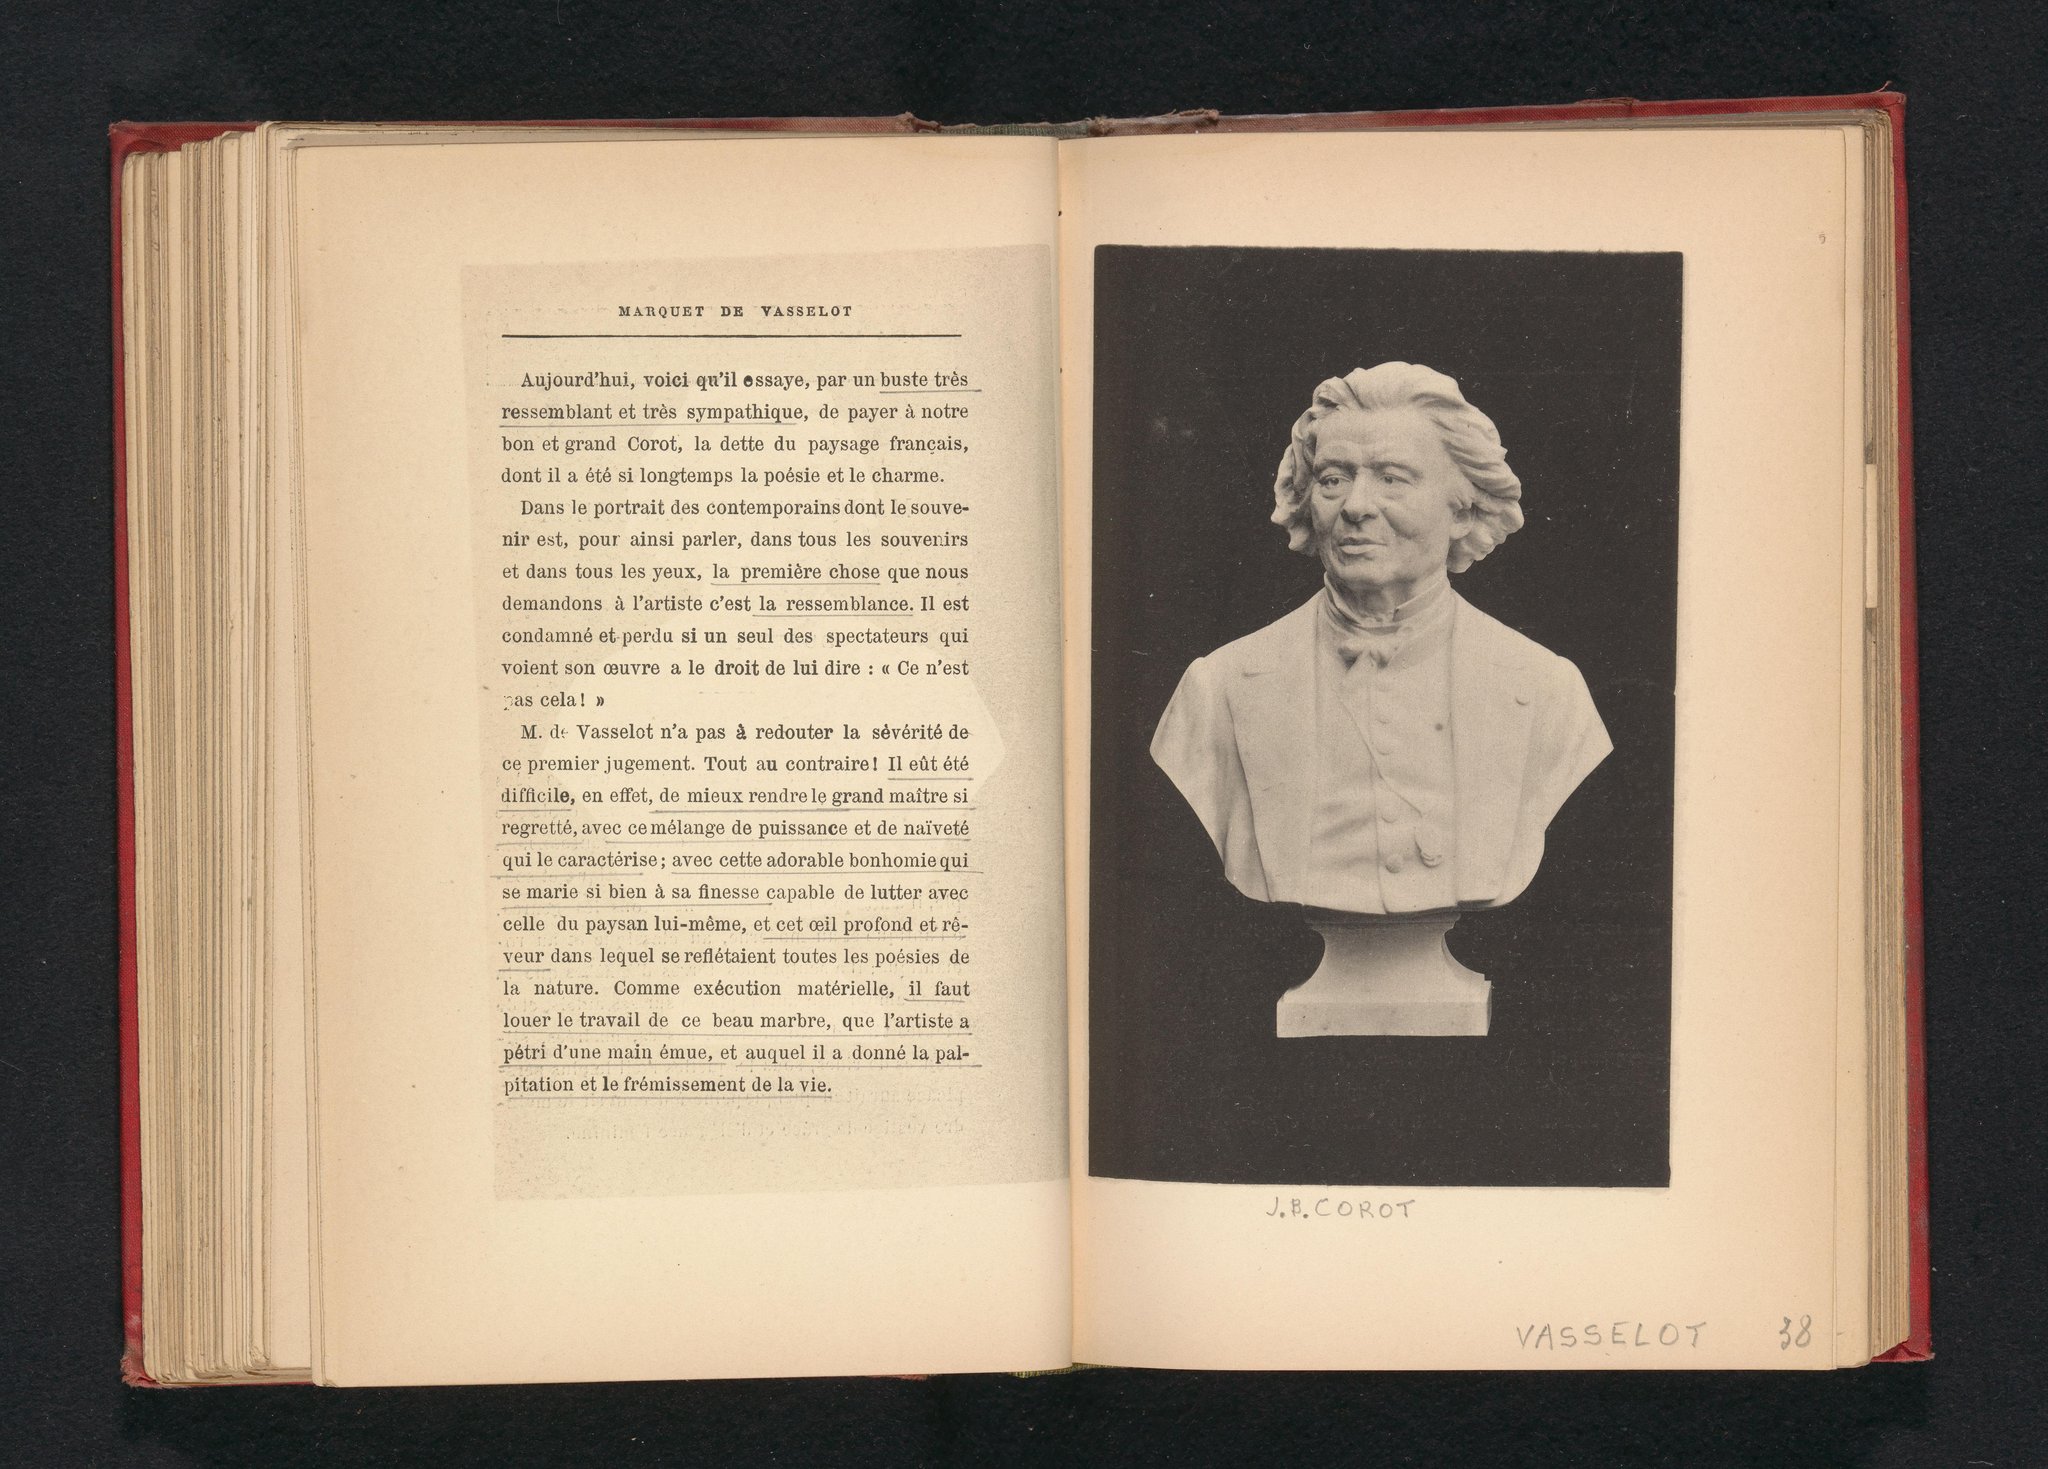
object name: page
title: Buste van Jean-Baptiste Corot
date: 1872-1882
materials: paper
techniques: photograph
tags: historical persons (portraits and scenes from the life) (+ (full) bust portrait), painter in non-work situation